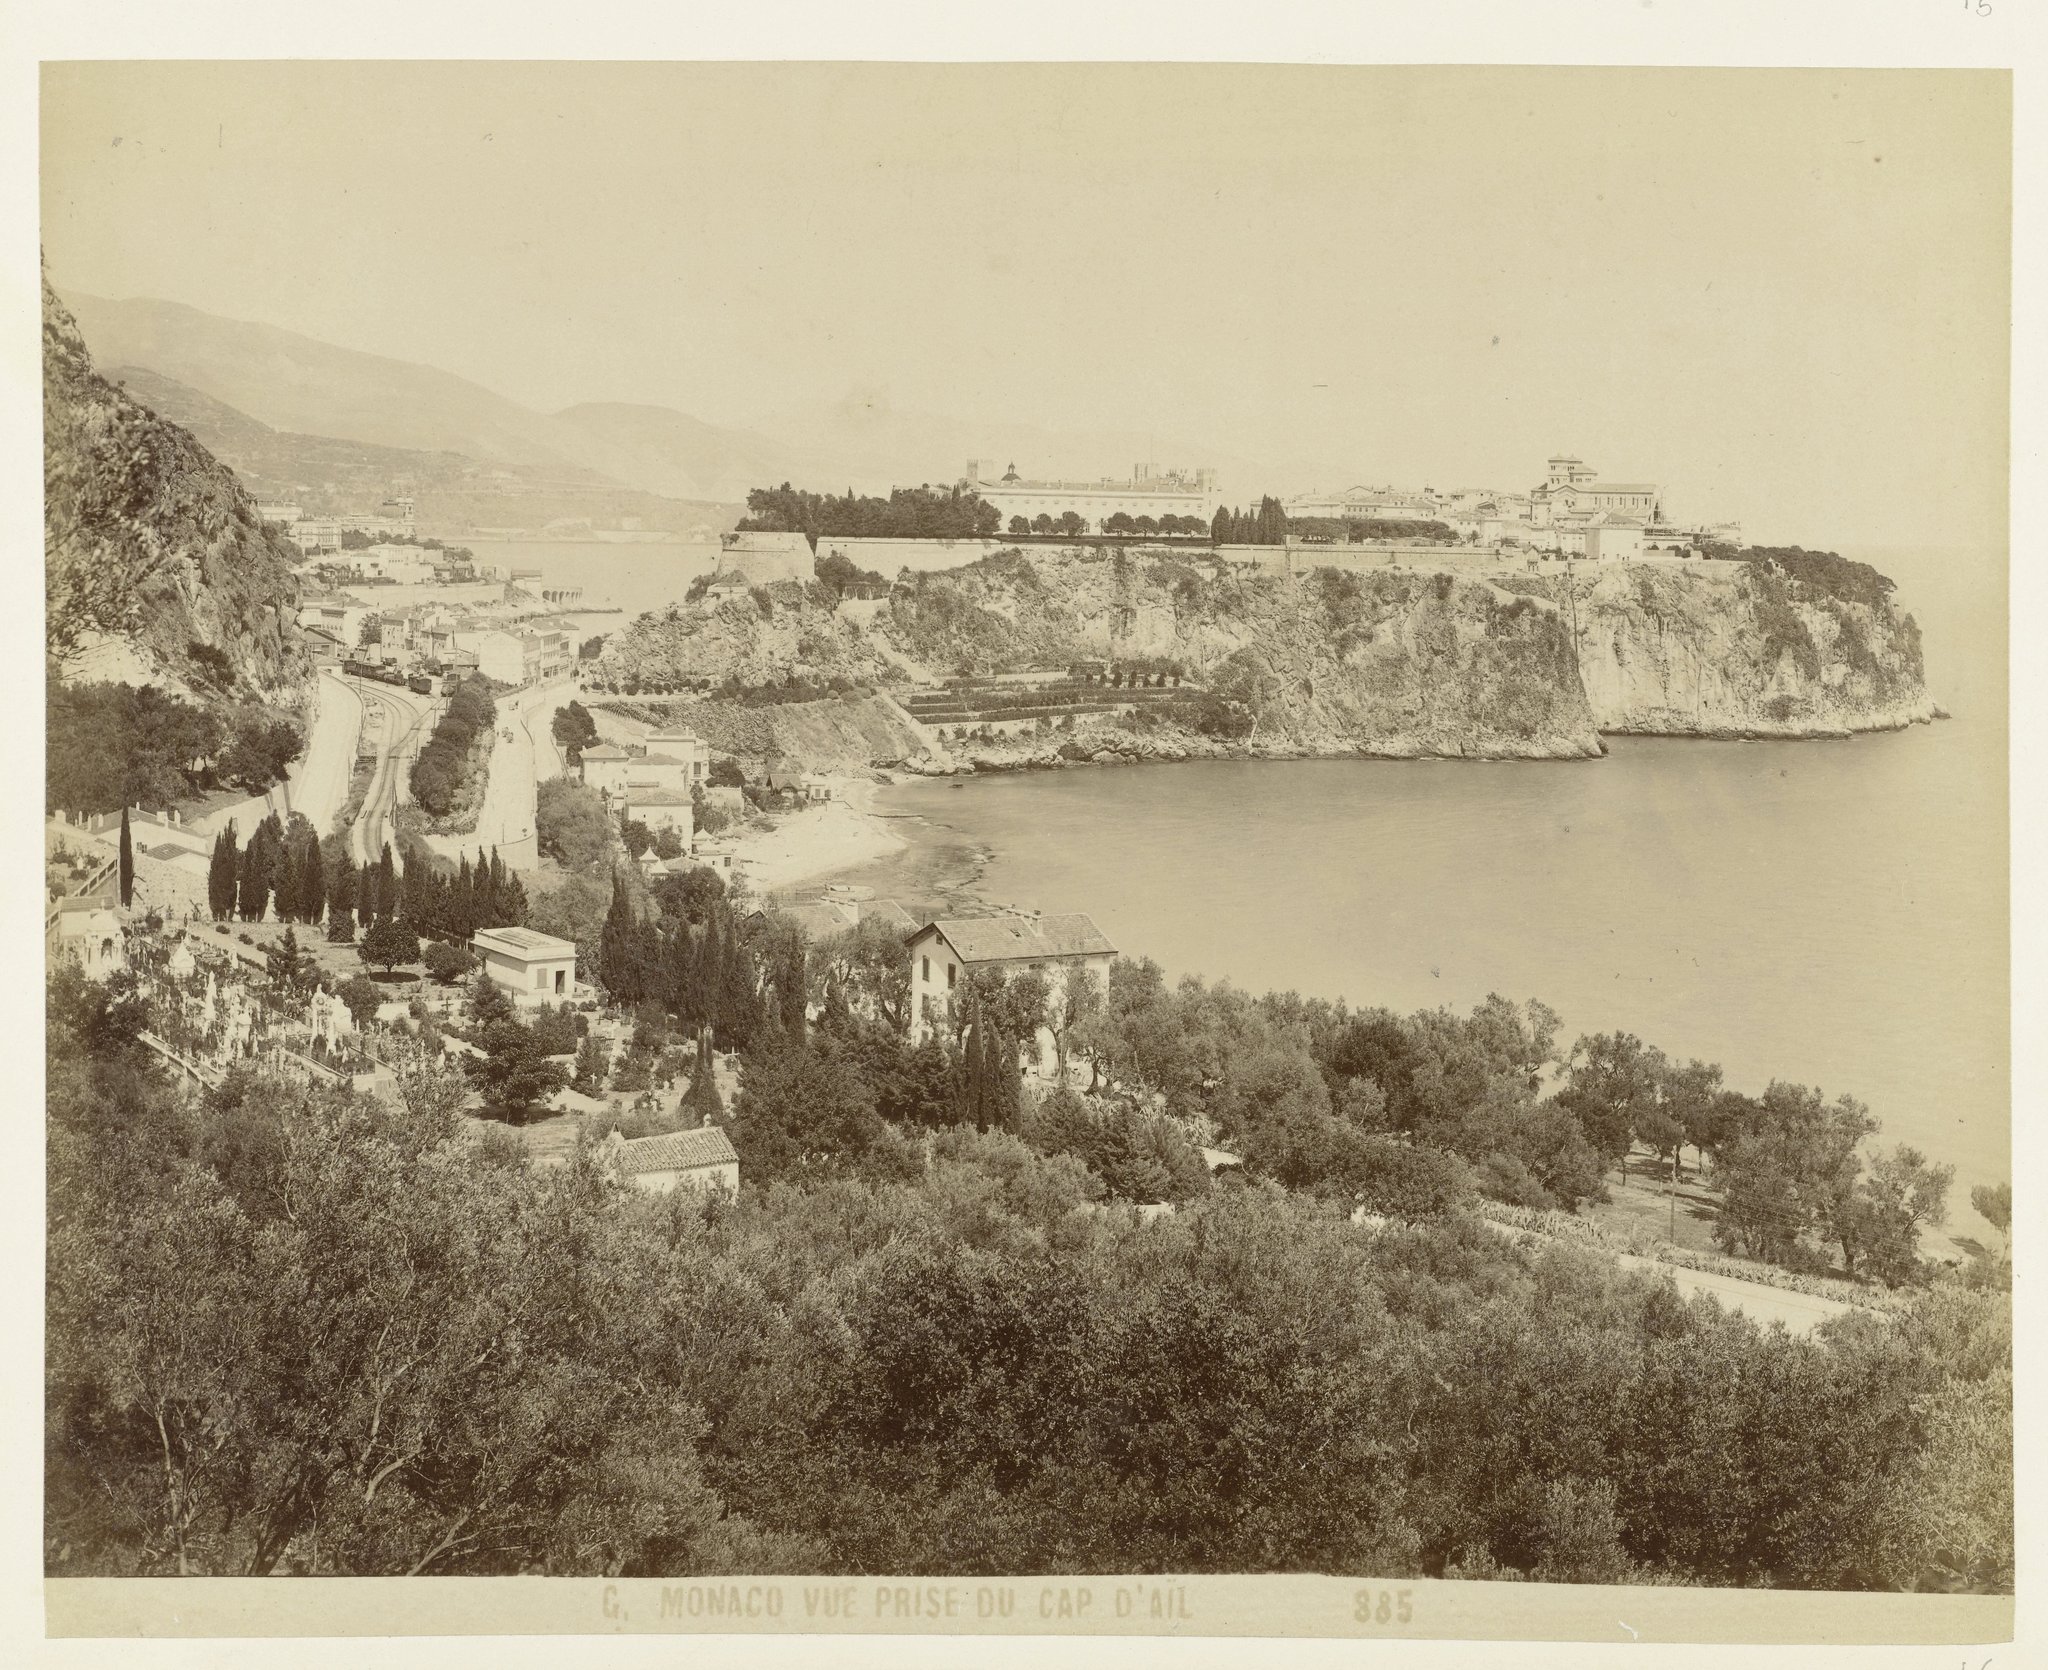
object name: photograph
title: Gezicht op Cap d'ail en de zee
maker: henry pauw van wieldrecht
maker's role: fotograaf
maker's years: 1863-1912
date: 1886-1896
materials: cardboard, photographic support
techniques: albumen print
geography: france